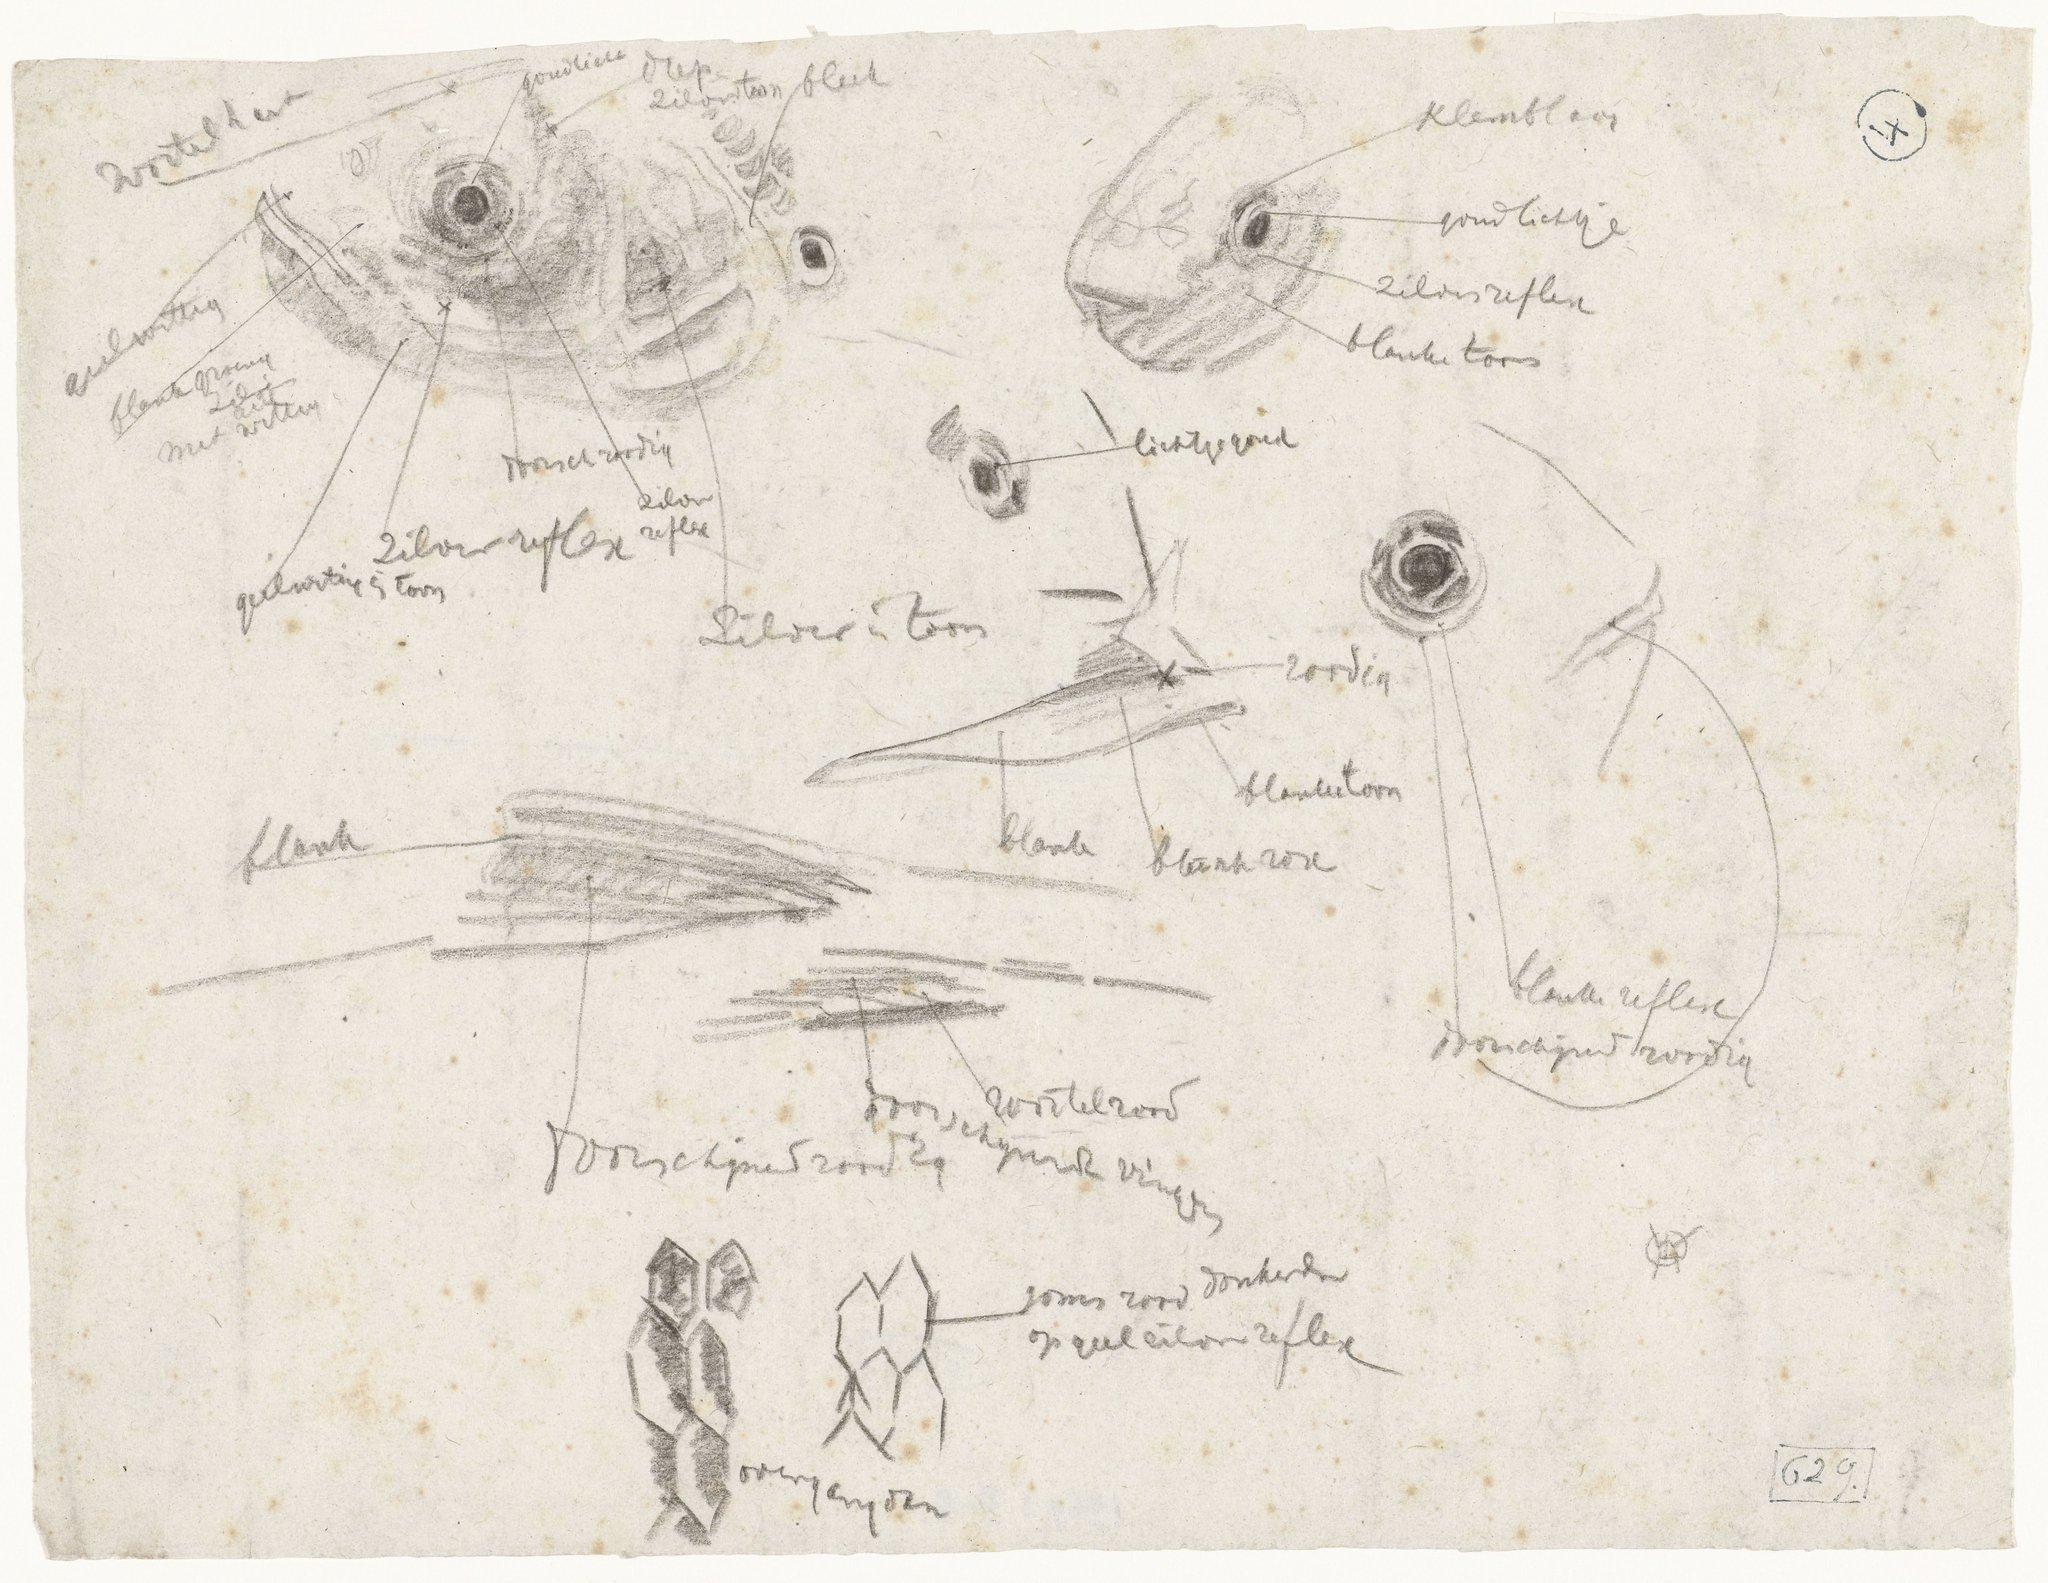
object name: drawing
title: Detailstudies van vissen, met kleurnotities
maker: gerrit willem dijsselhof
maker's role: designer, draughtsman, print maker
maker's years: 1866-1924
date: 1876-1924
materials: chalk, paper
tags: bony fishes